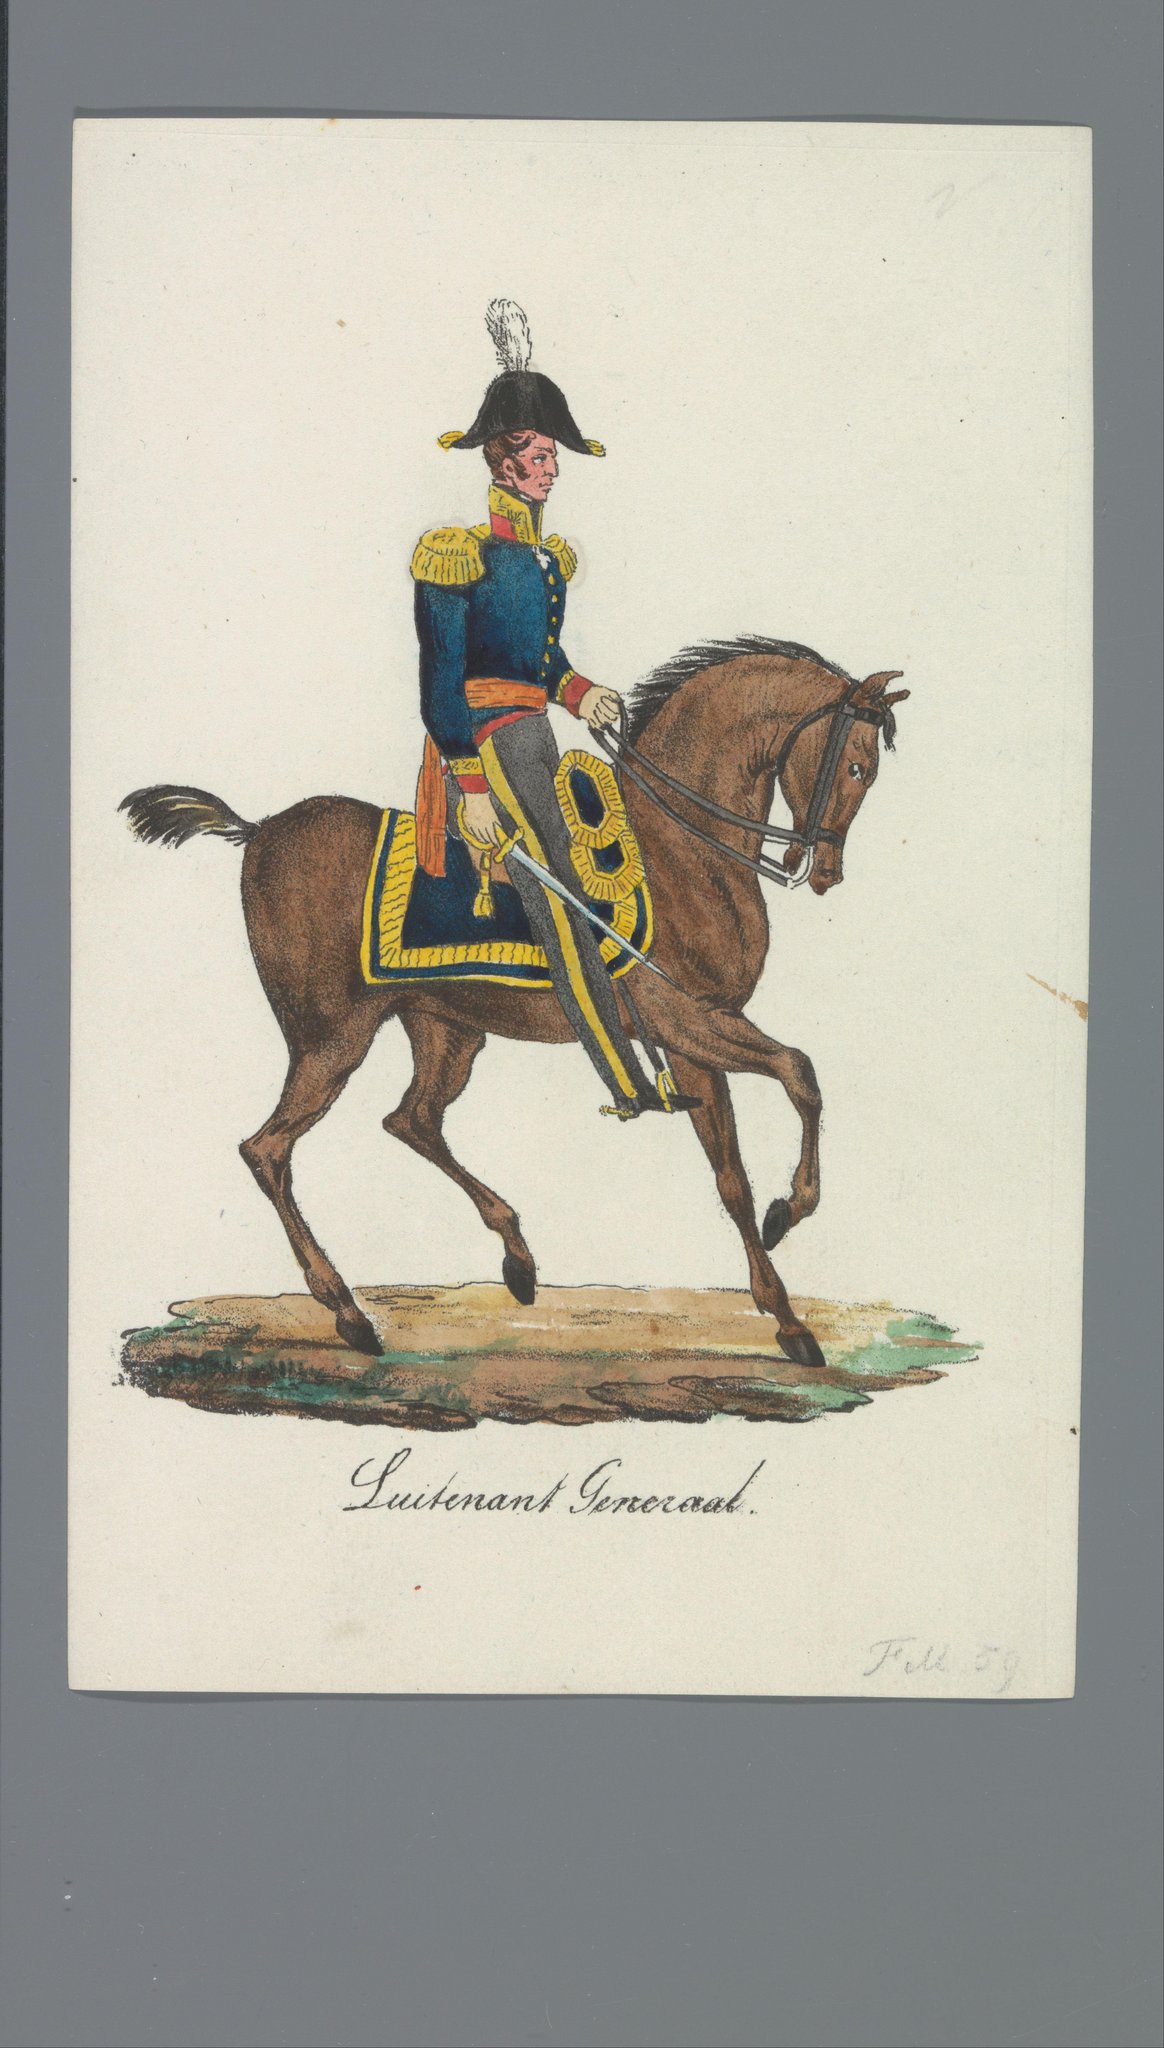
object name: costume print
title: Luitenant Generaal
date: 1835-1850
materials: paper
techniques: hand coloring, lithograph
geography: netherlands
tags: (military) uniforms, clothes, costume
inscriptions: collector's mark: Lugt 2228, collector's mark: Lugt 2227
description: Luitenant-Generaal te paard met ontbloot degen. Lid van de Generale Staf. Onderdeel van een serie van 157 losse bladen met Nederlandse militaire uniformen in de jaren 1830-1832.